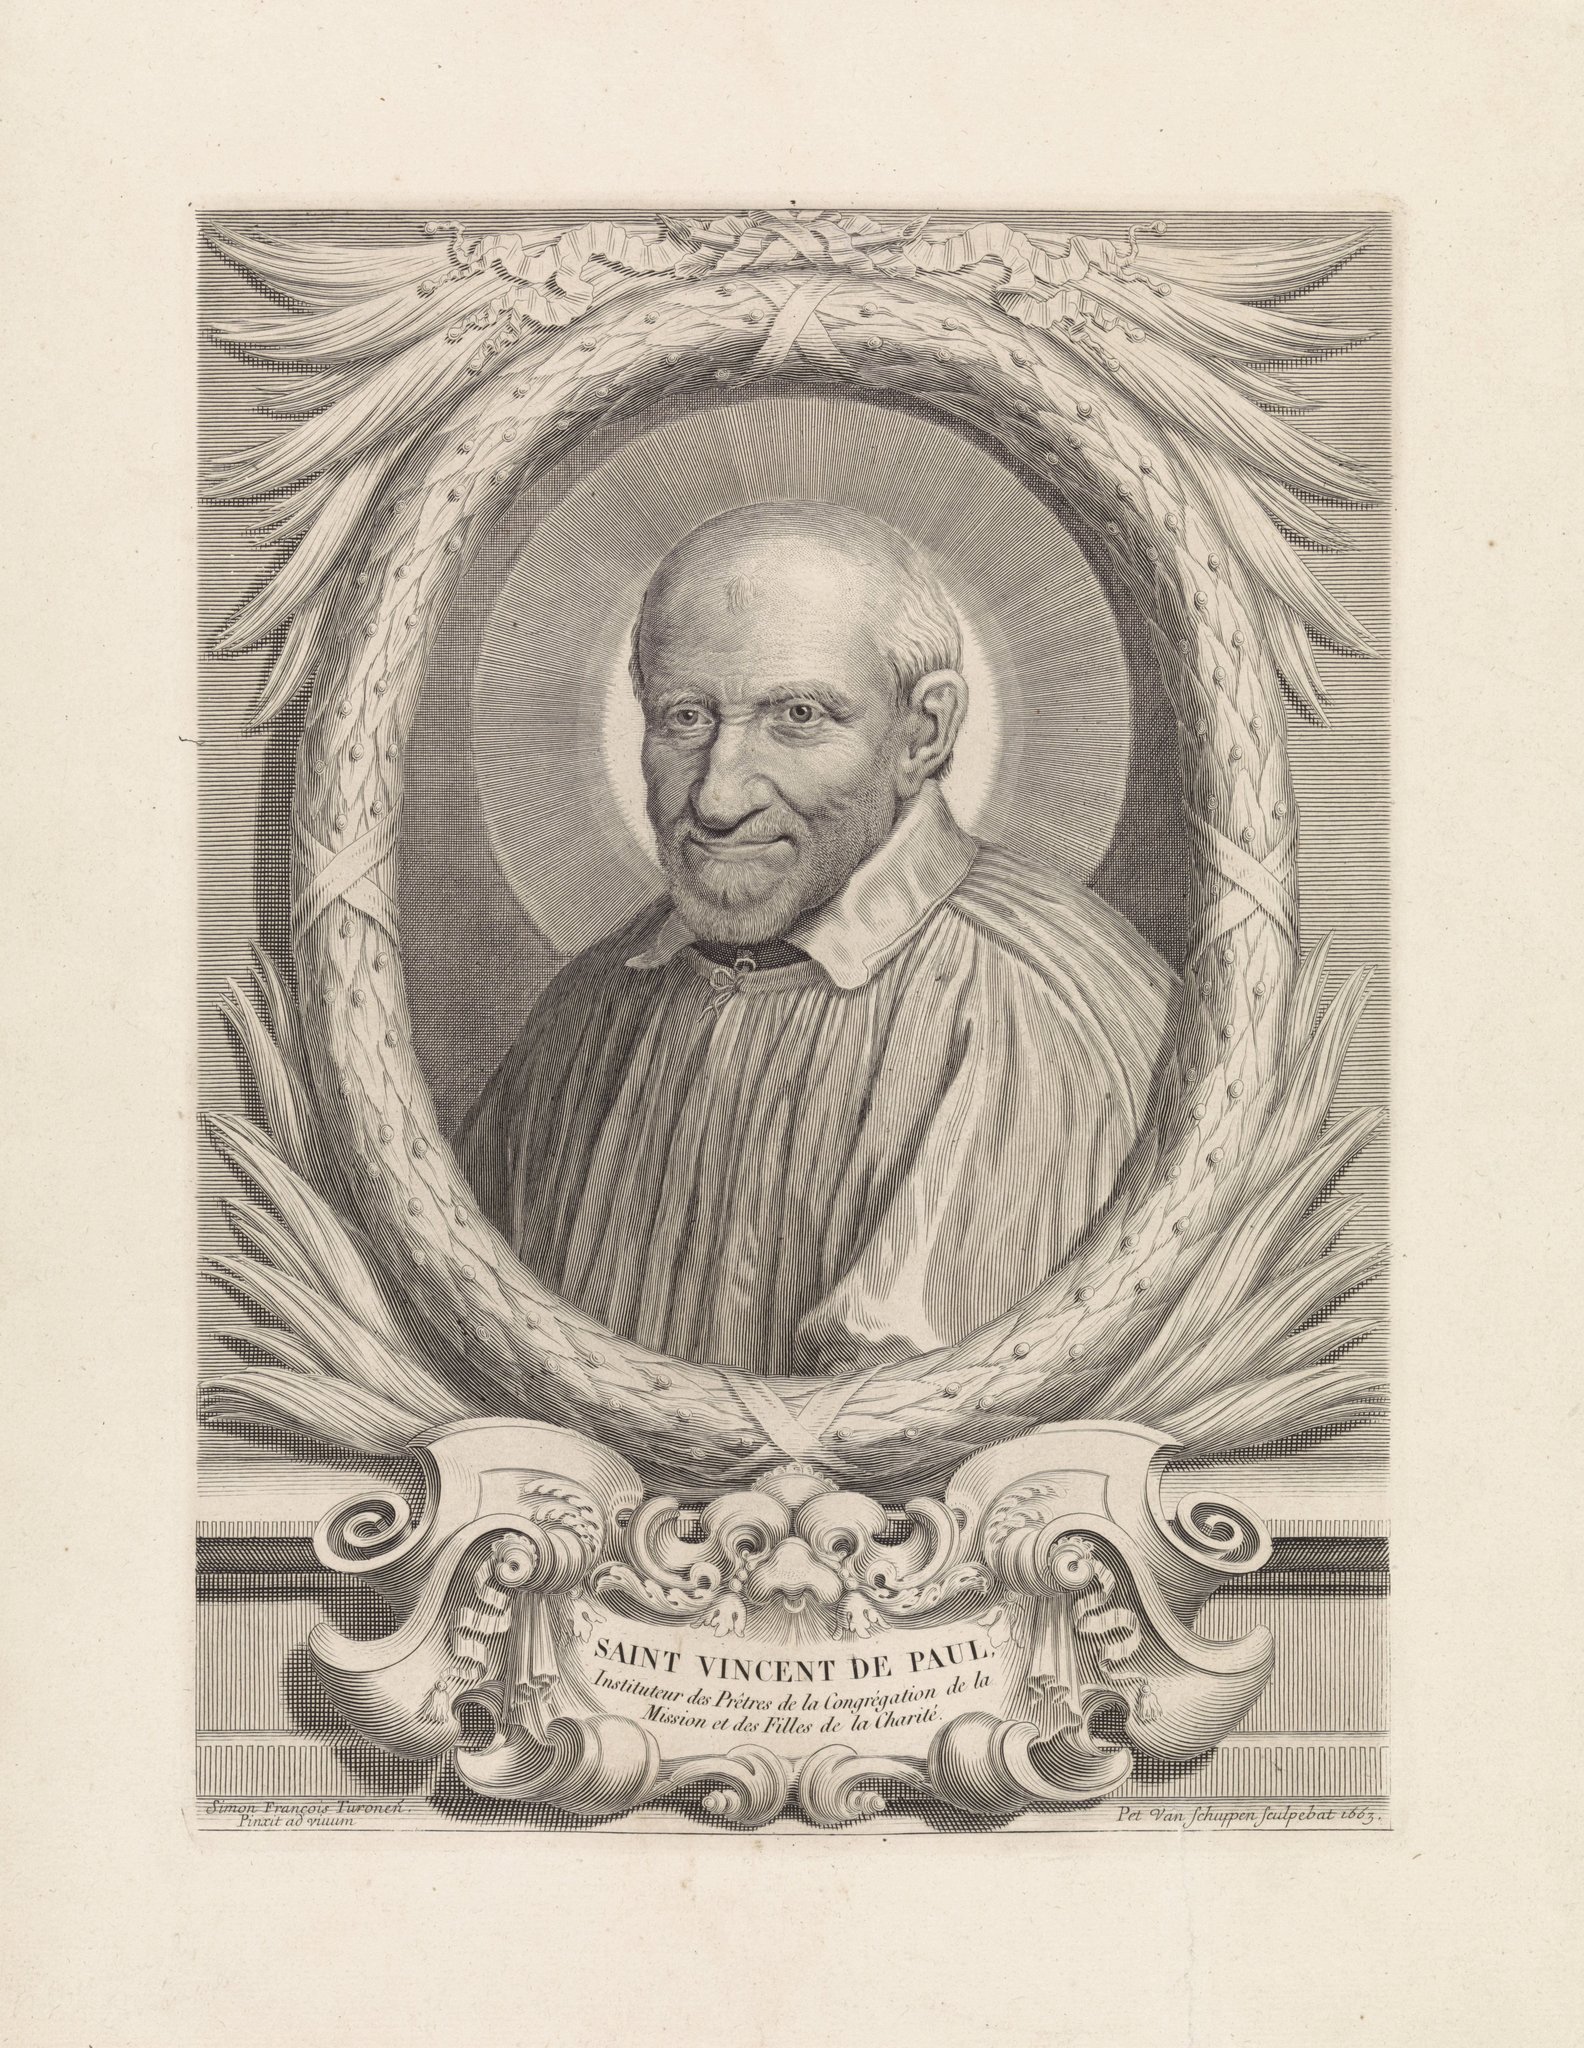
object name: print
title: Portret van de H. Vincent de Paul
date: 1608-1663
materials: paper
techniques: engraving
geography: paris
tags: nimbus, halo ~ radiance emanating from persons or things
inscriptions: collector's mark: Lugt 2228